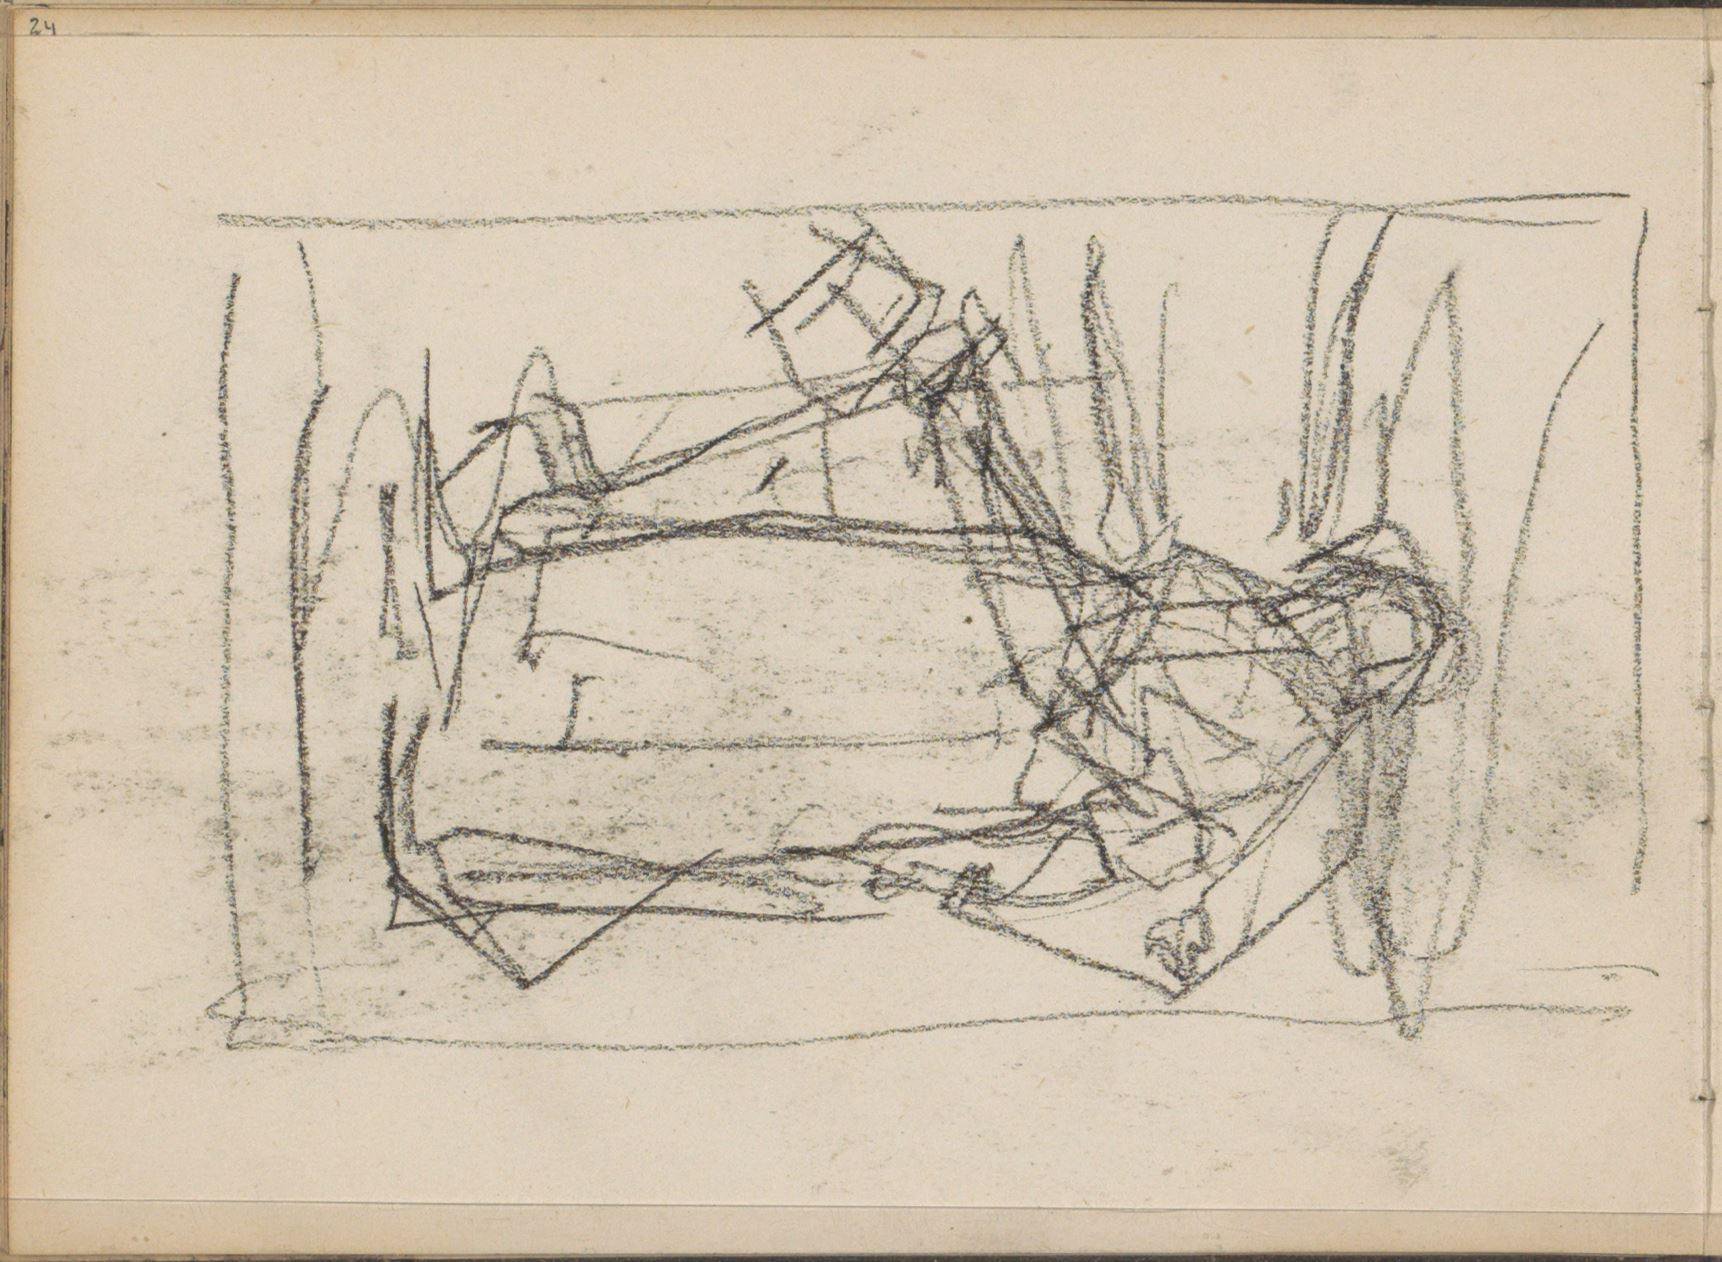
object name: sketchbook leaf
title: Staande figuur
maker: marius bauer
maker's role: draughtsman, print maker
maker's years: 1867-1932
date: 1877-1932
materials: chalk, paper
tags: standing figure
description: Pagina 24 uit een schetsboek met 32 bladen.